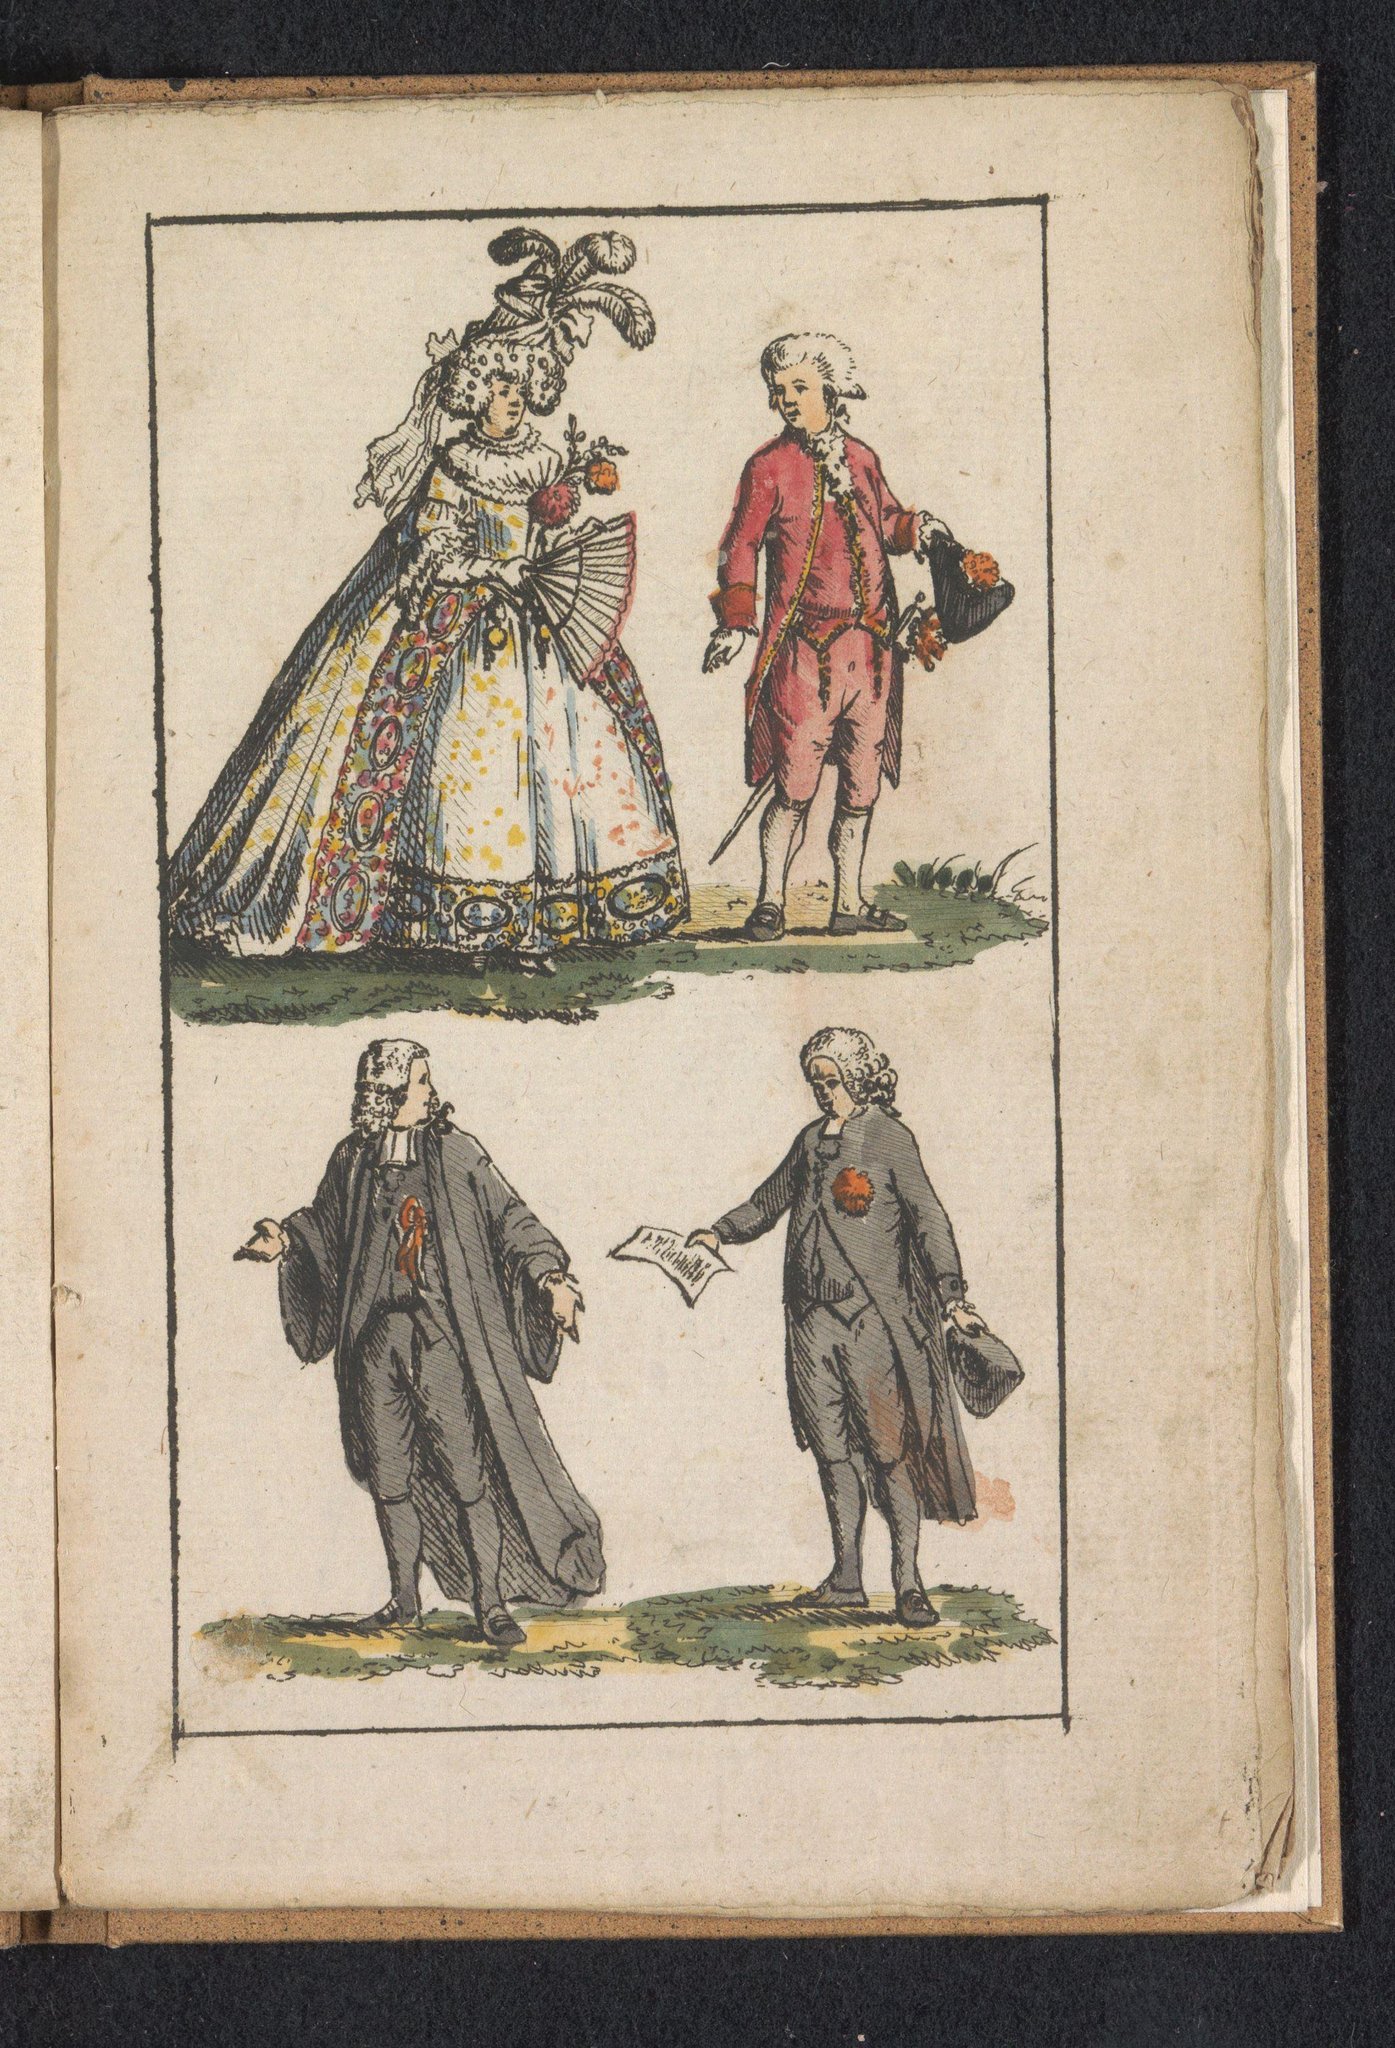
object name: book illustration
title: Aanzienlijke dame en heer van het hof / Raadsheer en advocaat van het hof, 1792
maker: Anonymous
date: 1792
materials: paper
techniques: etching, hand coloring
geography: northern netherlands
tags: clothes, costume (+ women's clothes), clothes, costume (+ men's clothes), patriots (1780-1795)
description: Kleding rond 1791-1792. Boven: een aanzienlijke dame en heer van het stadhouderlijke hof, zoals gekleed bij de inhaling van de prins en prinses in Den Haag op 1 november 1791. Onder: een raadsheer krijgt van een advocaat van het stadhouderlijke hof een geschrift overhandigd. Illustratie in een boekje over mode en de dracht van oranje kokarde.